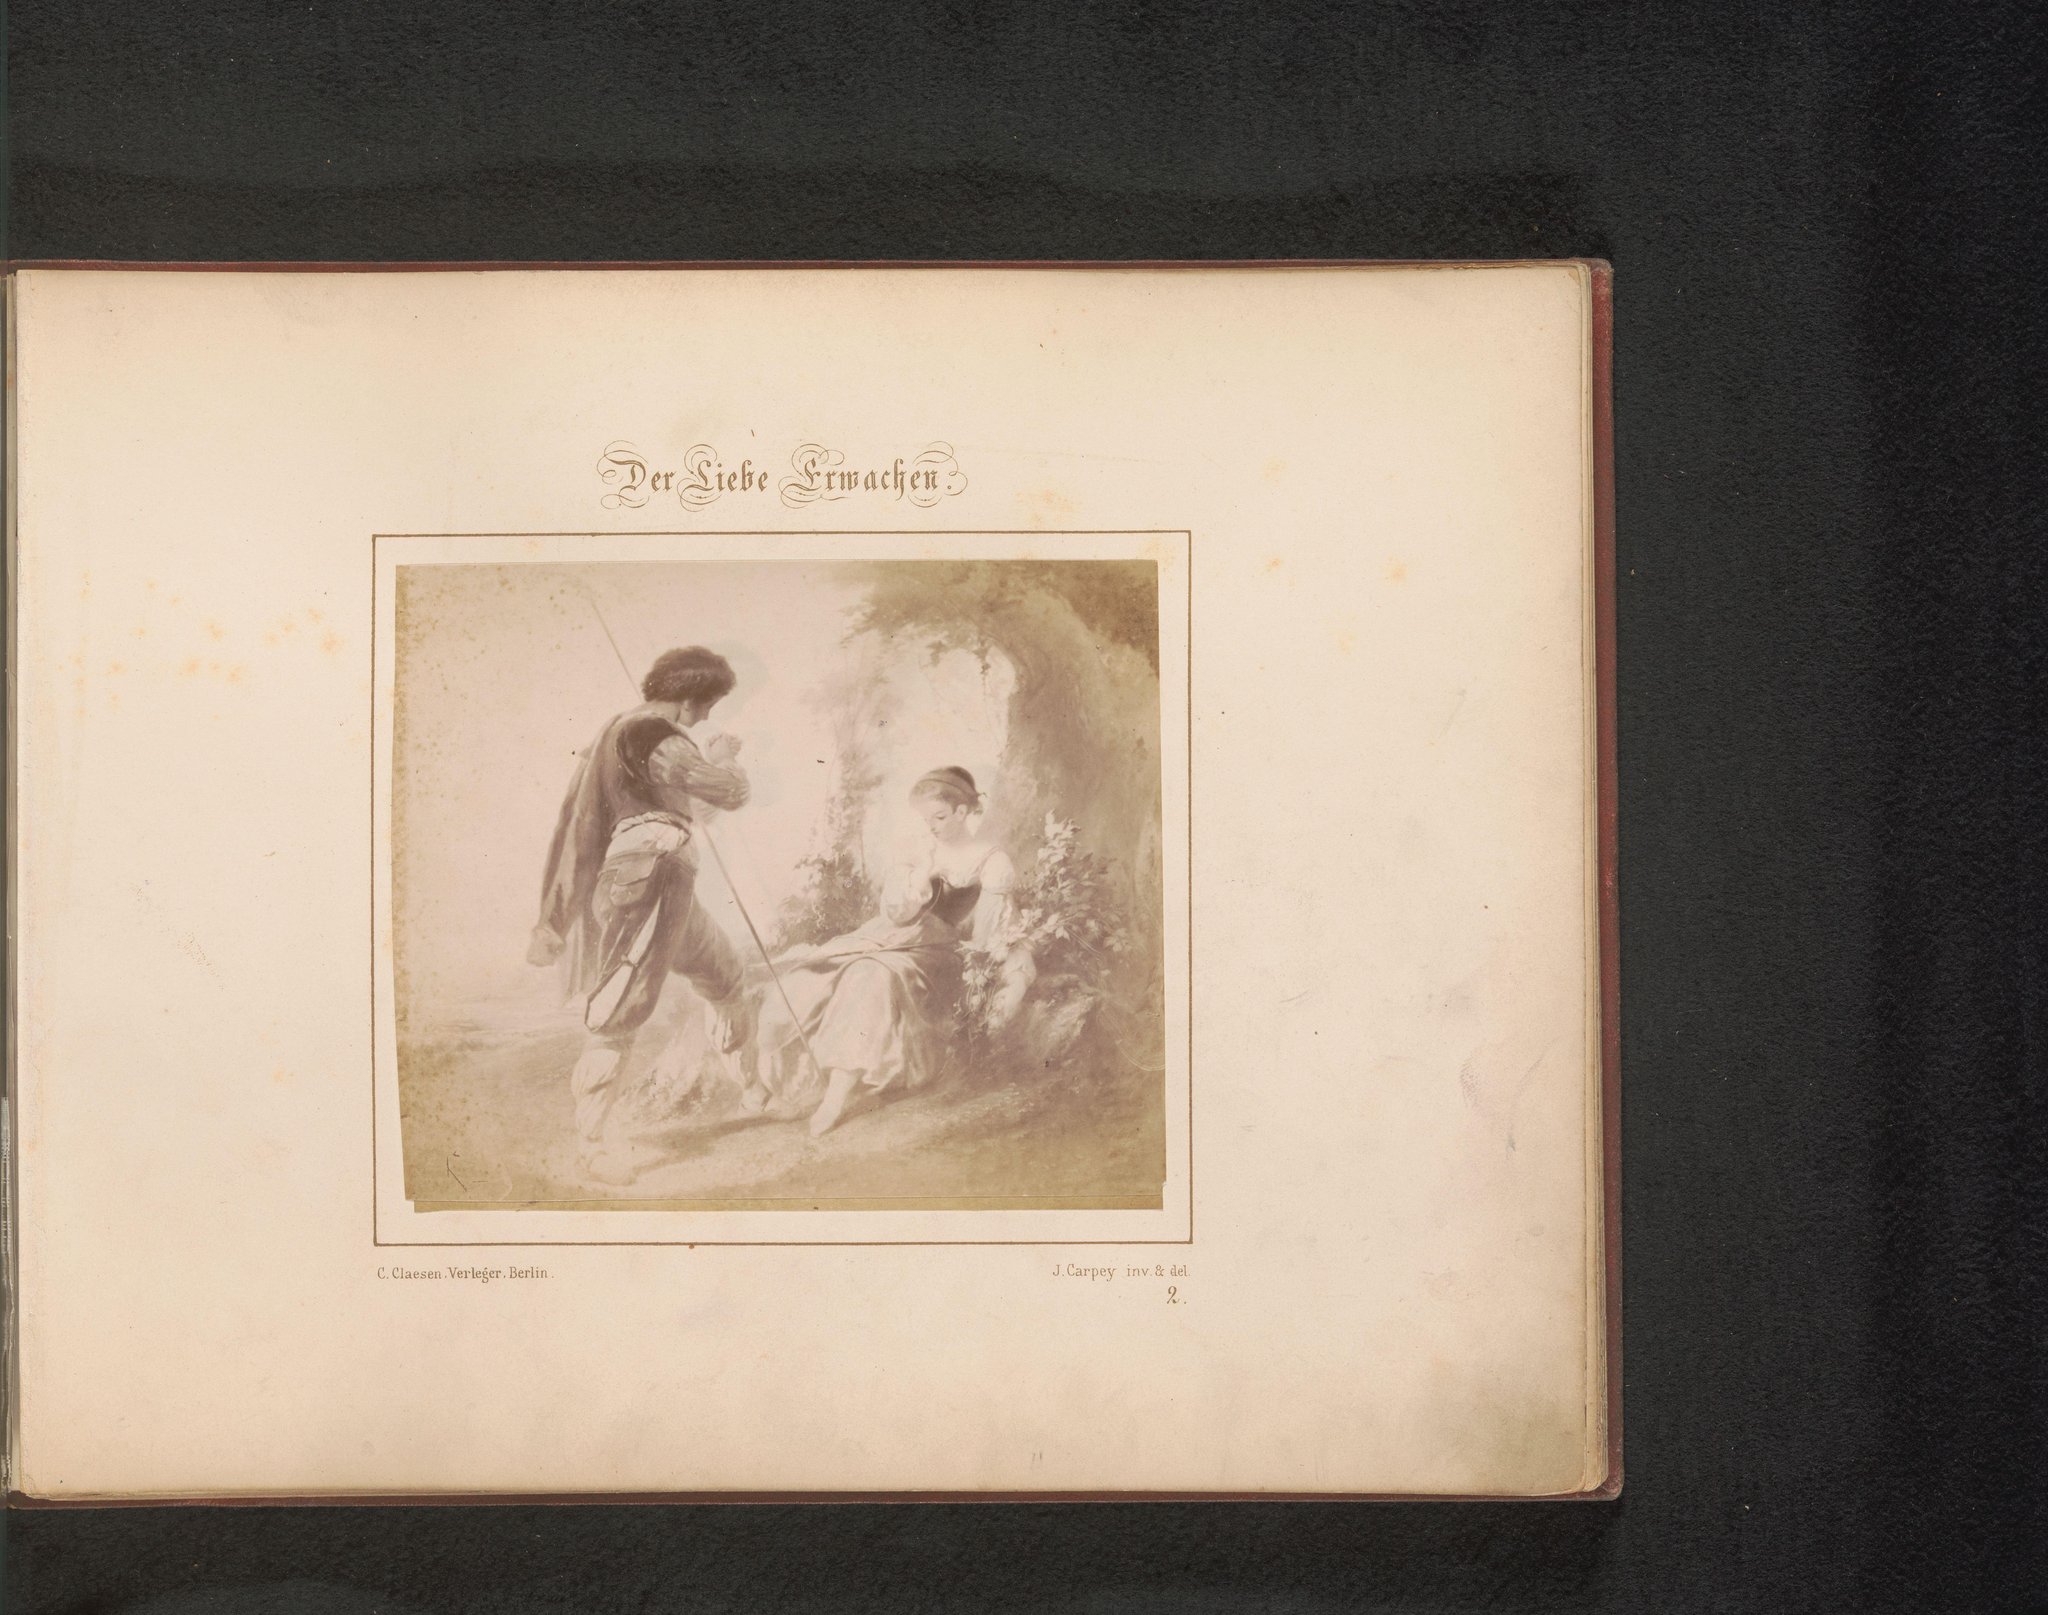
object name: reproduction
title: Der Liebe Erwachen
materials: photographic support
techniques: albumen print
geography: berlin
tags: couple of lovers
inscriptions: number: ‘2.’